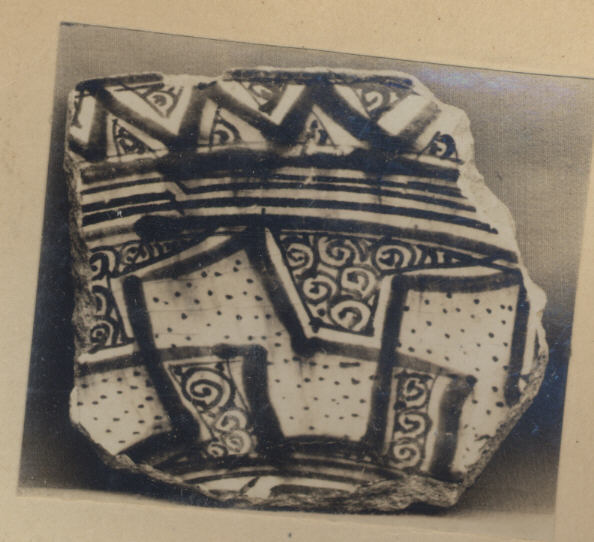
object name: fragment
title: Ceramic Fragment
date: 1301-1500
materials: stonepaste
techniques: painting, underglaze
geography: egypt